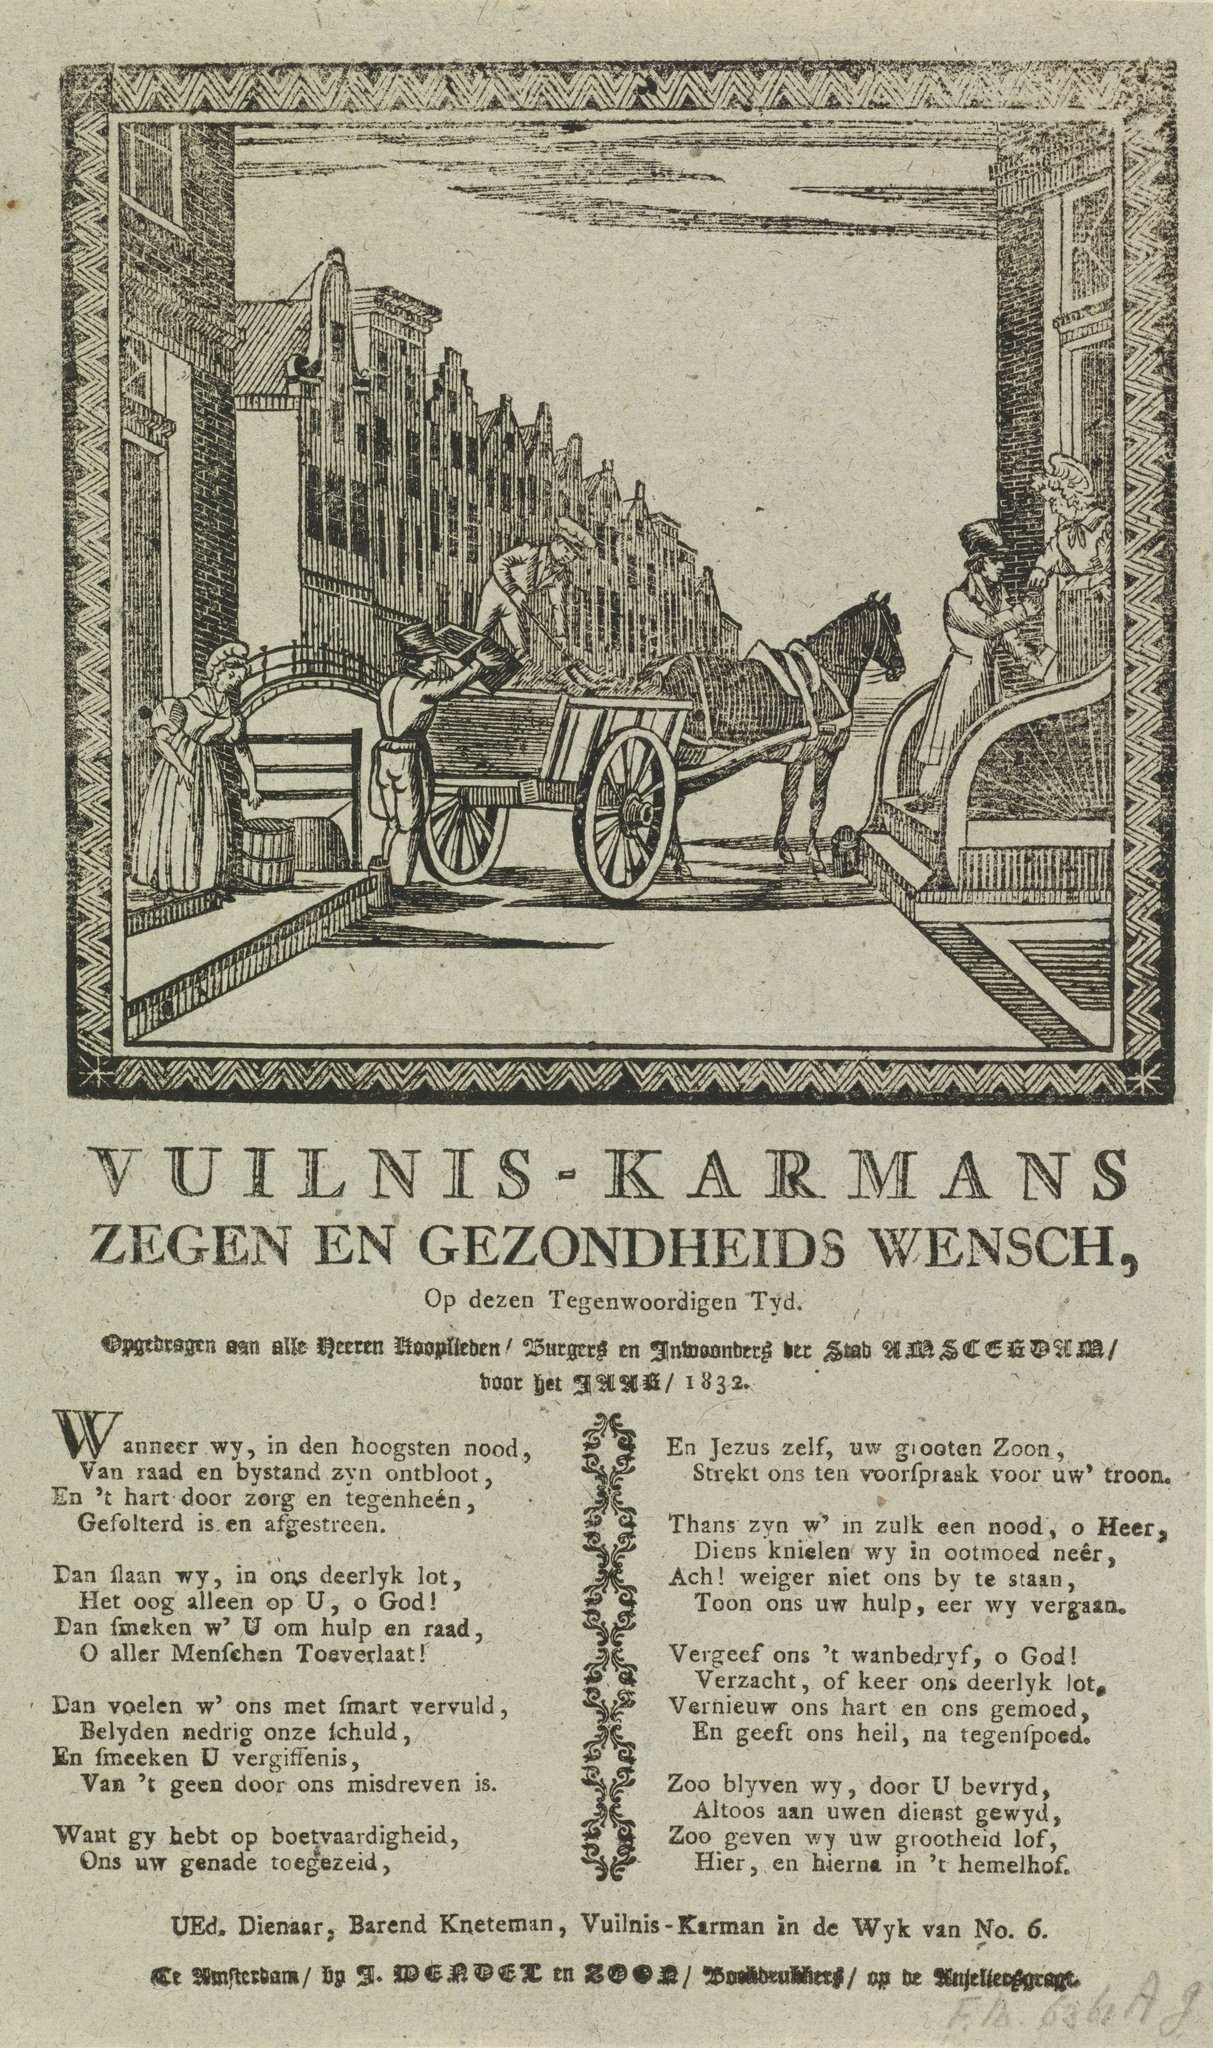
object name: print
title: Vuilnis-karmans zegen en gezondheids wensch, op dezen Tegenwoordigen Tyd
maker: Anonymous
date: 1831-1832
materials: paper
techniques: letterpress printing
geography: amsterdam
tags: street, garbage collection, amsterdam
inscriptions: collector's mark: Lugt 2228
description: Nieuwjaarswens van de Amsterdamse vuilnismannen voor het jaar 1832. Gezicht in een straat te Amsterdam waar twee mannen het vuil in een kar laden. Een andere man haalt bij een huis geld op. Met gedicht in twee kolommen. Van de vuilniskarman in de wijk no. 6: Barend Kneteman.